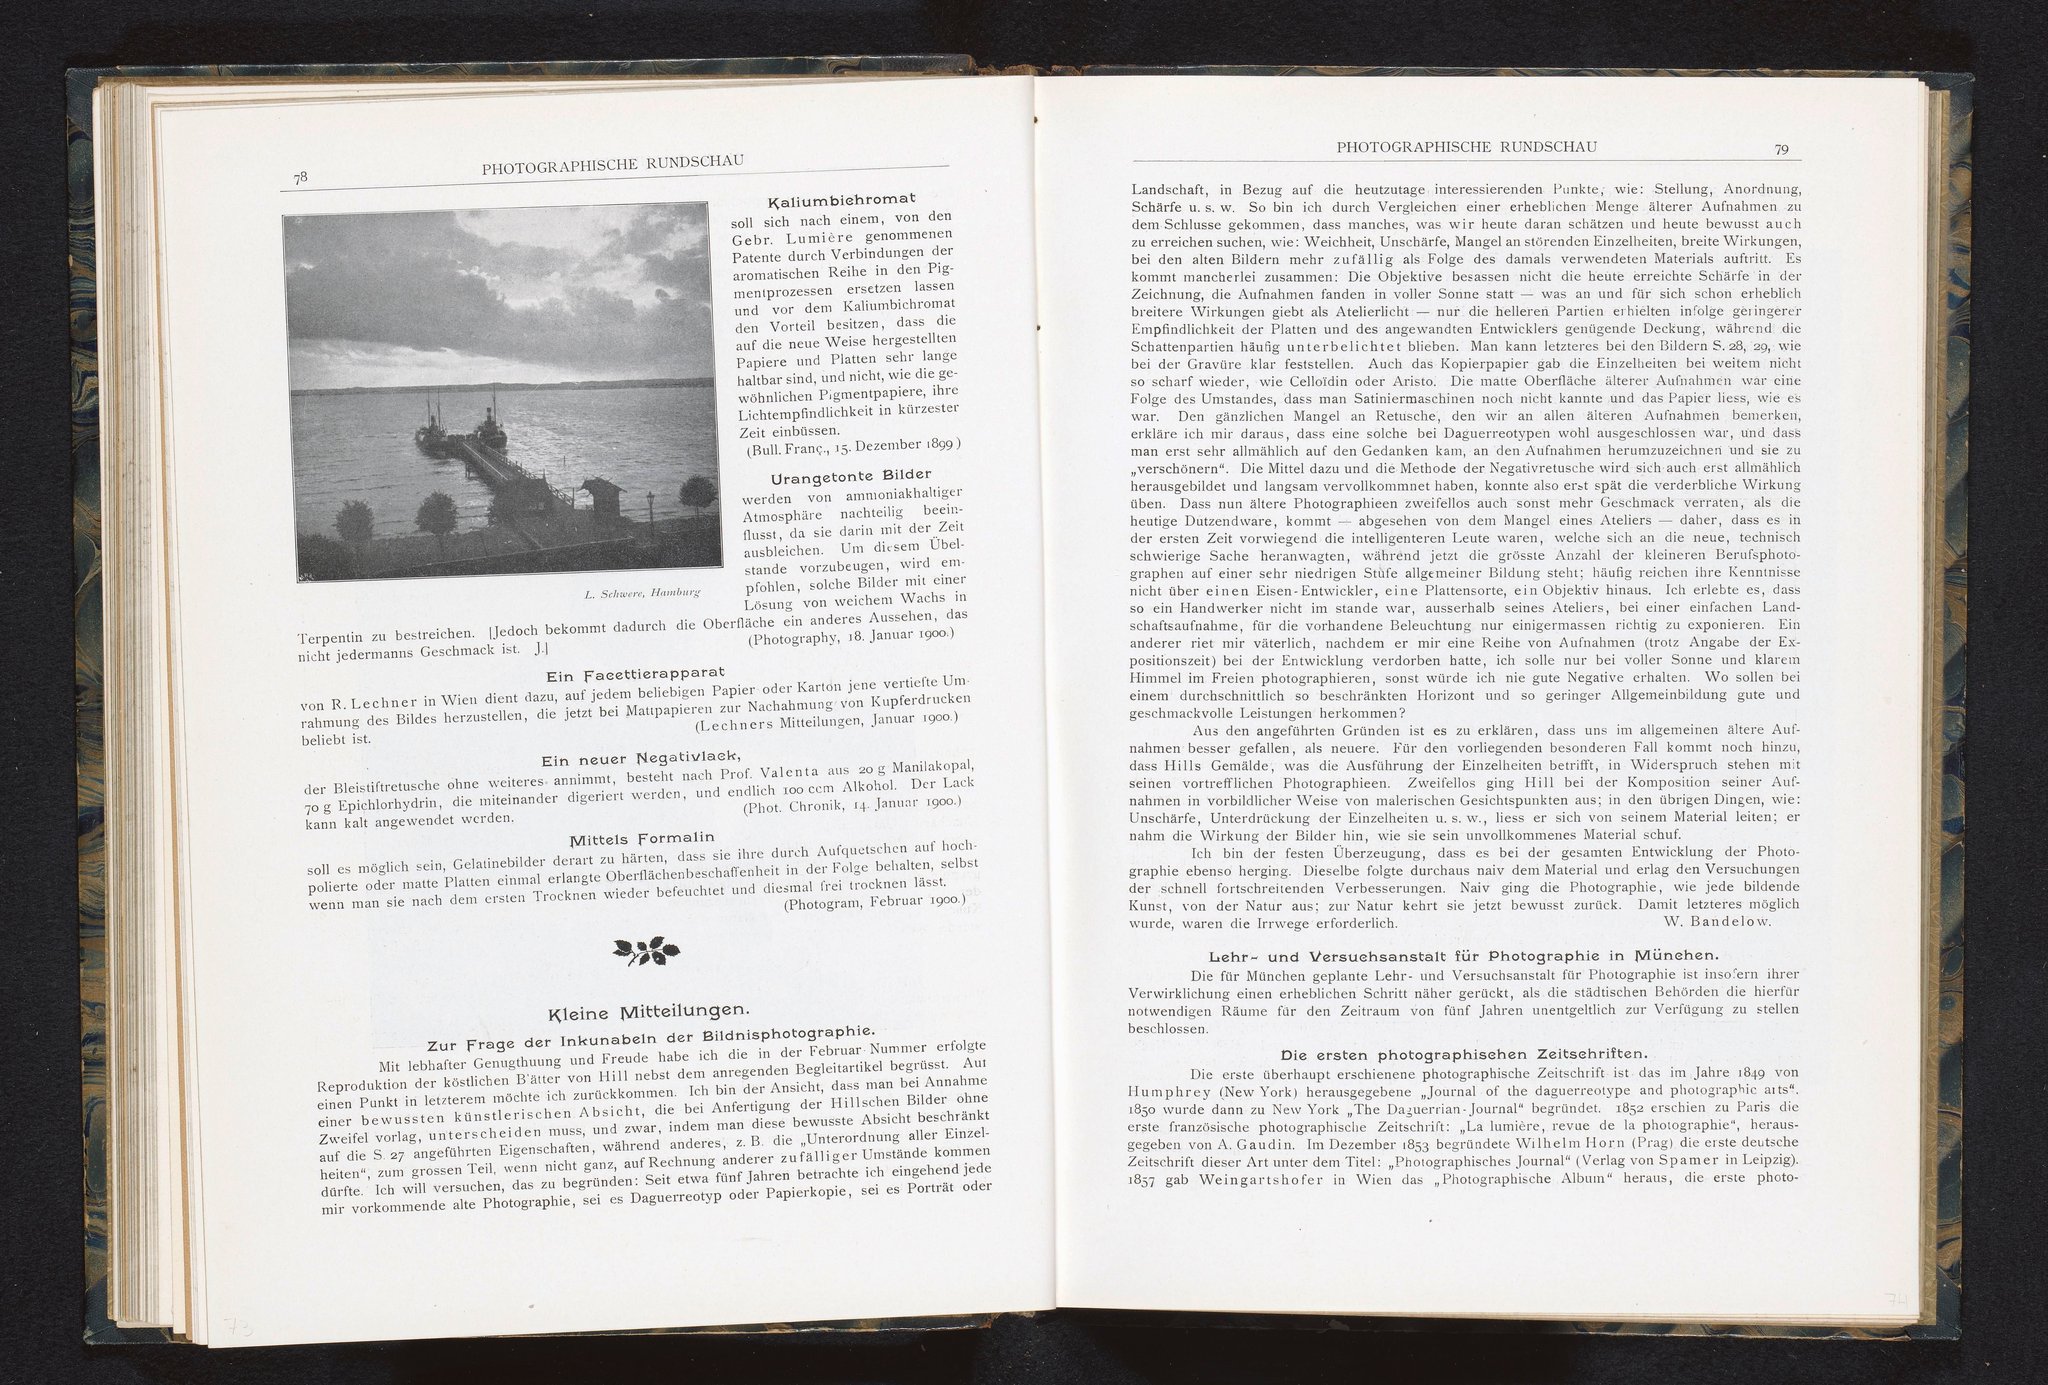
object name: page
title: Gezicht op een pier aan het water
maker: l. schwere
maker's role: fotograaf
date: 1895-1900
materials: paper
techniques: autotype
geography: berlin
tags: landscapes with waters, waterscapes, seascapes (in the temperate zone), pier, quay, wharf